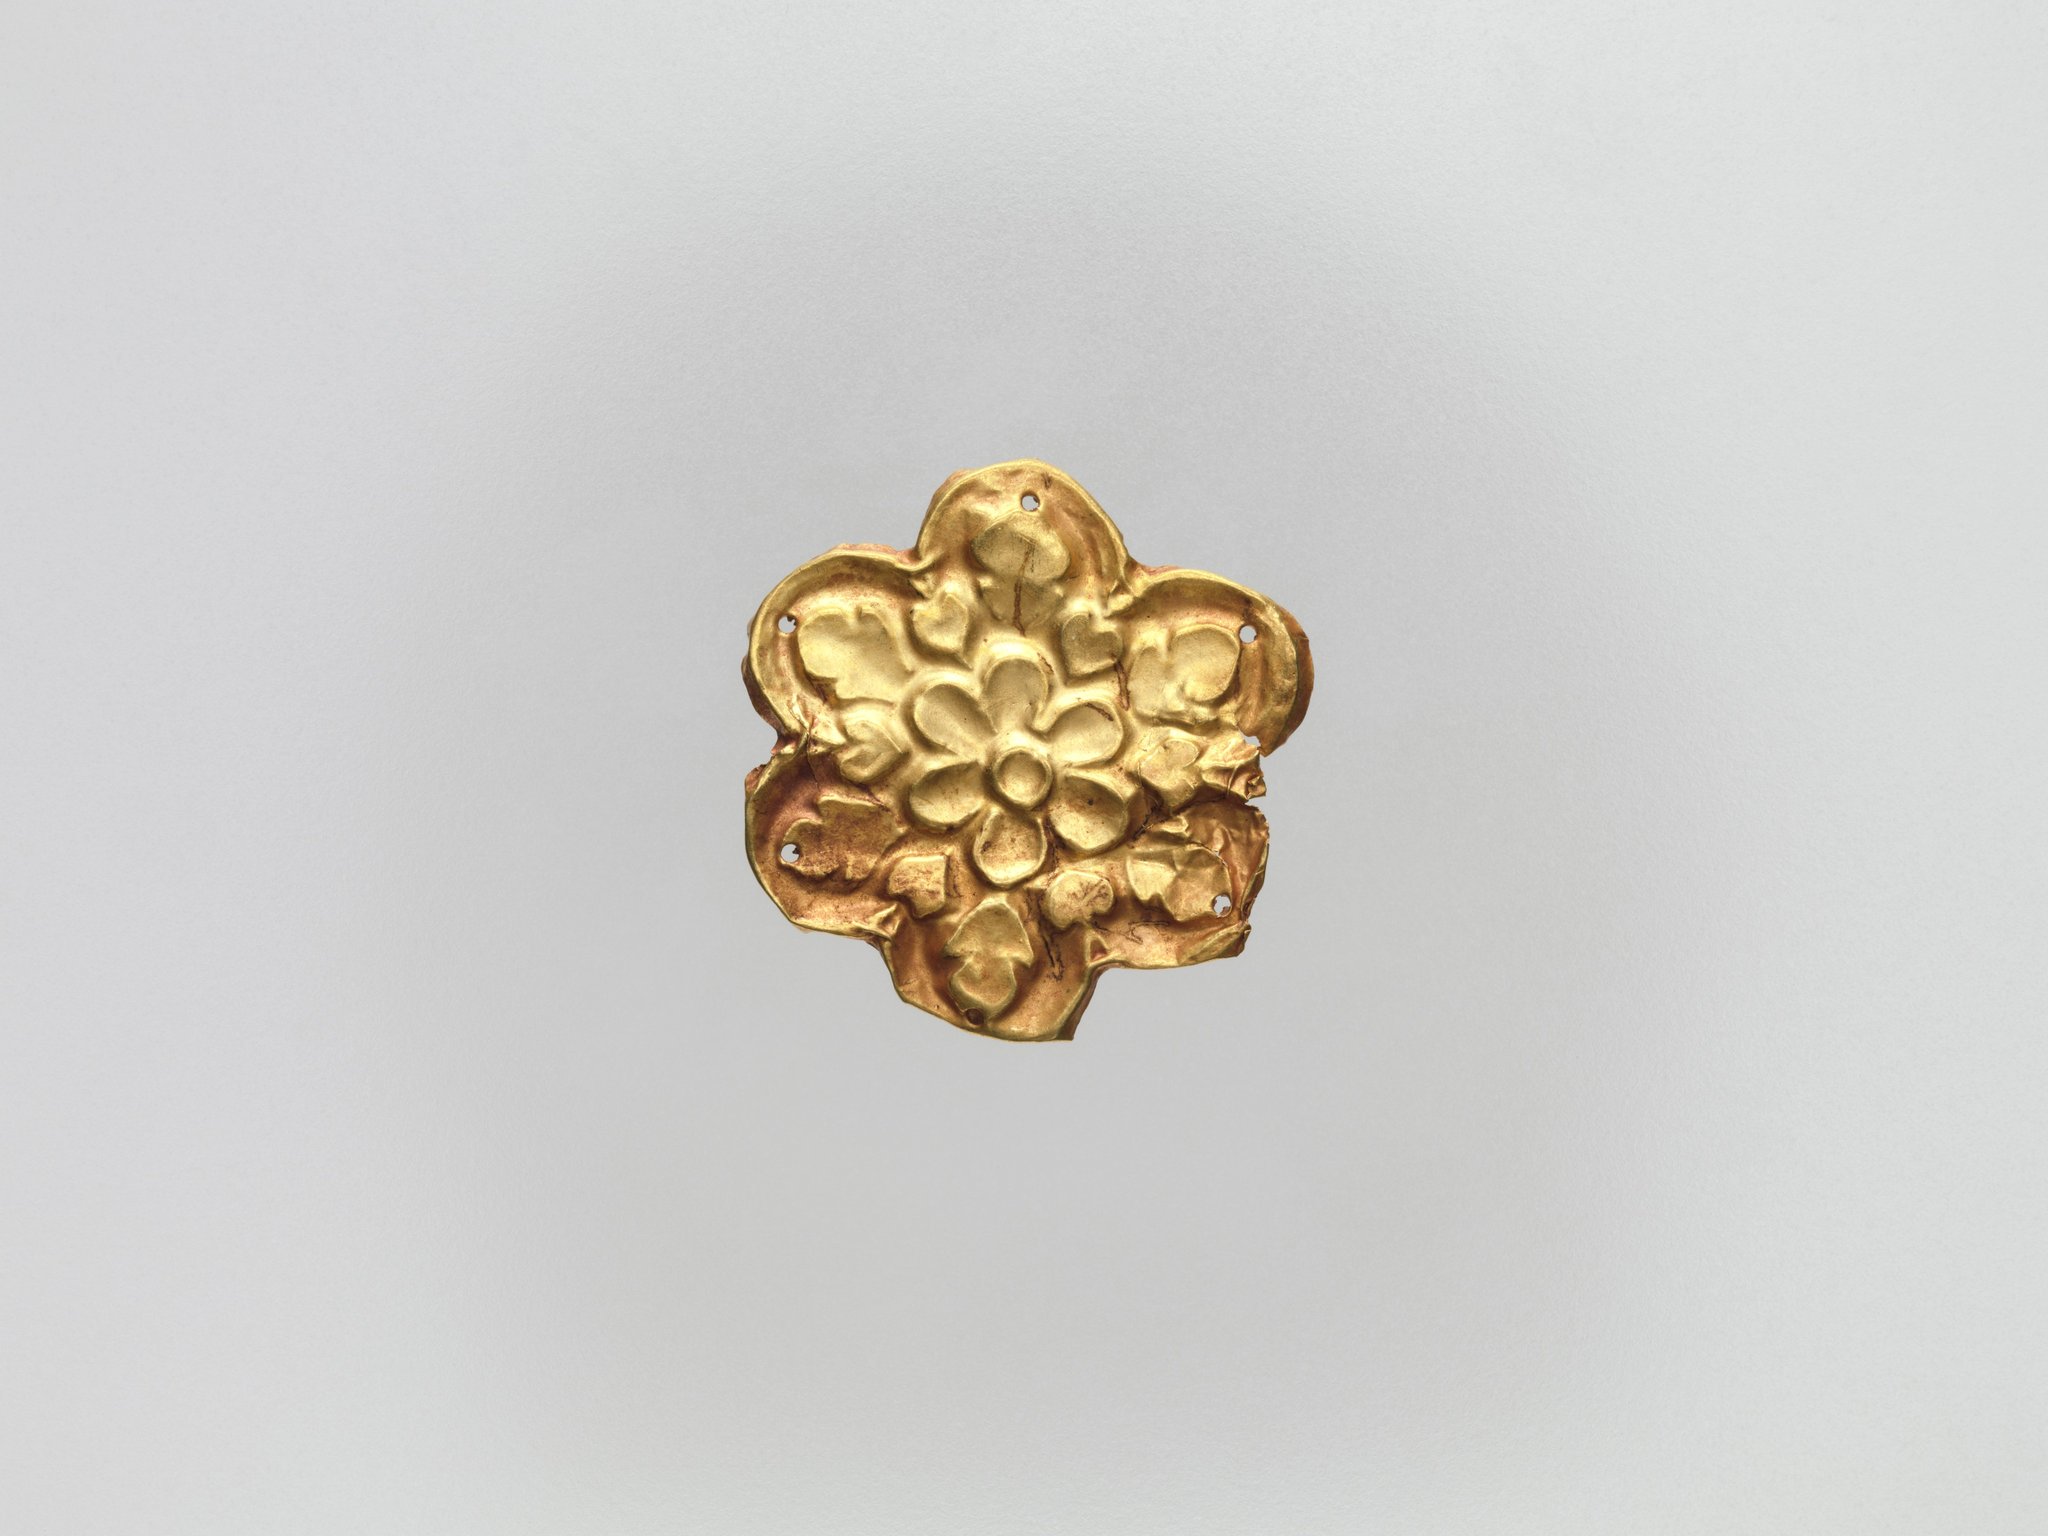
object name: garment plaque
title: Flower-Shaped Clothing Plaque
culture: chinese or central asian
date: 601-900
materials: gold